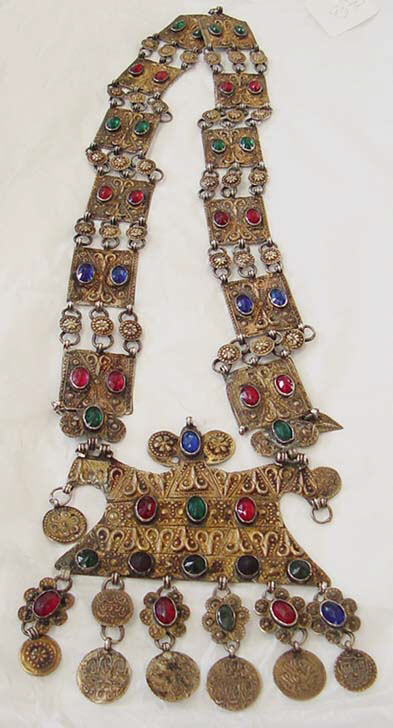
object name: necklace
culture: turkmen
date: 1867-1900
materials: metal, stone